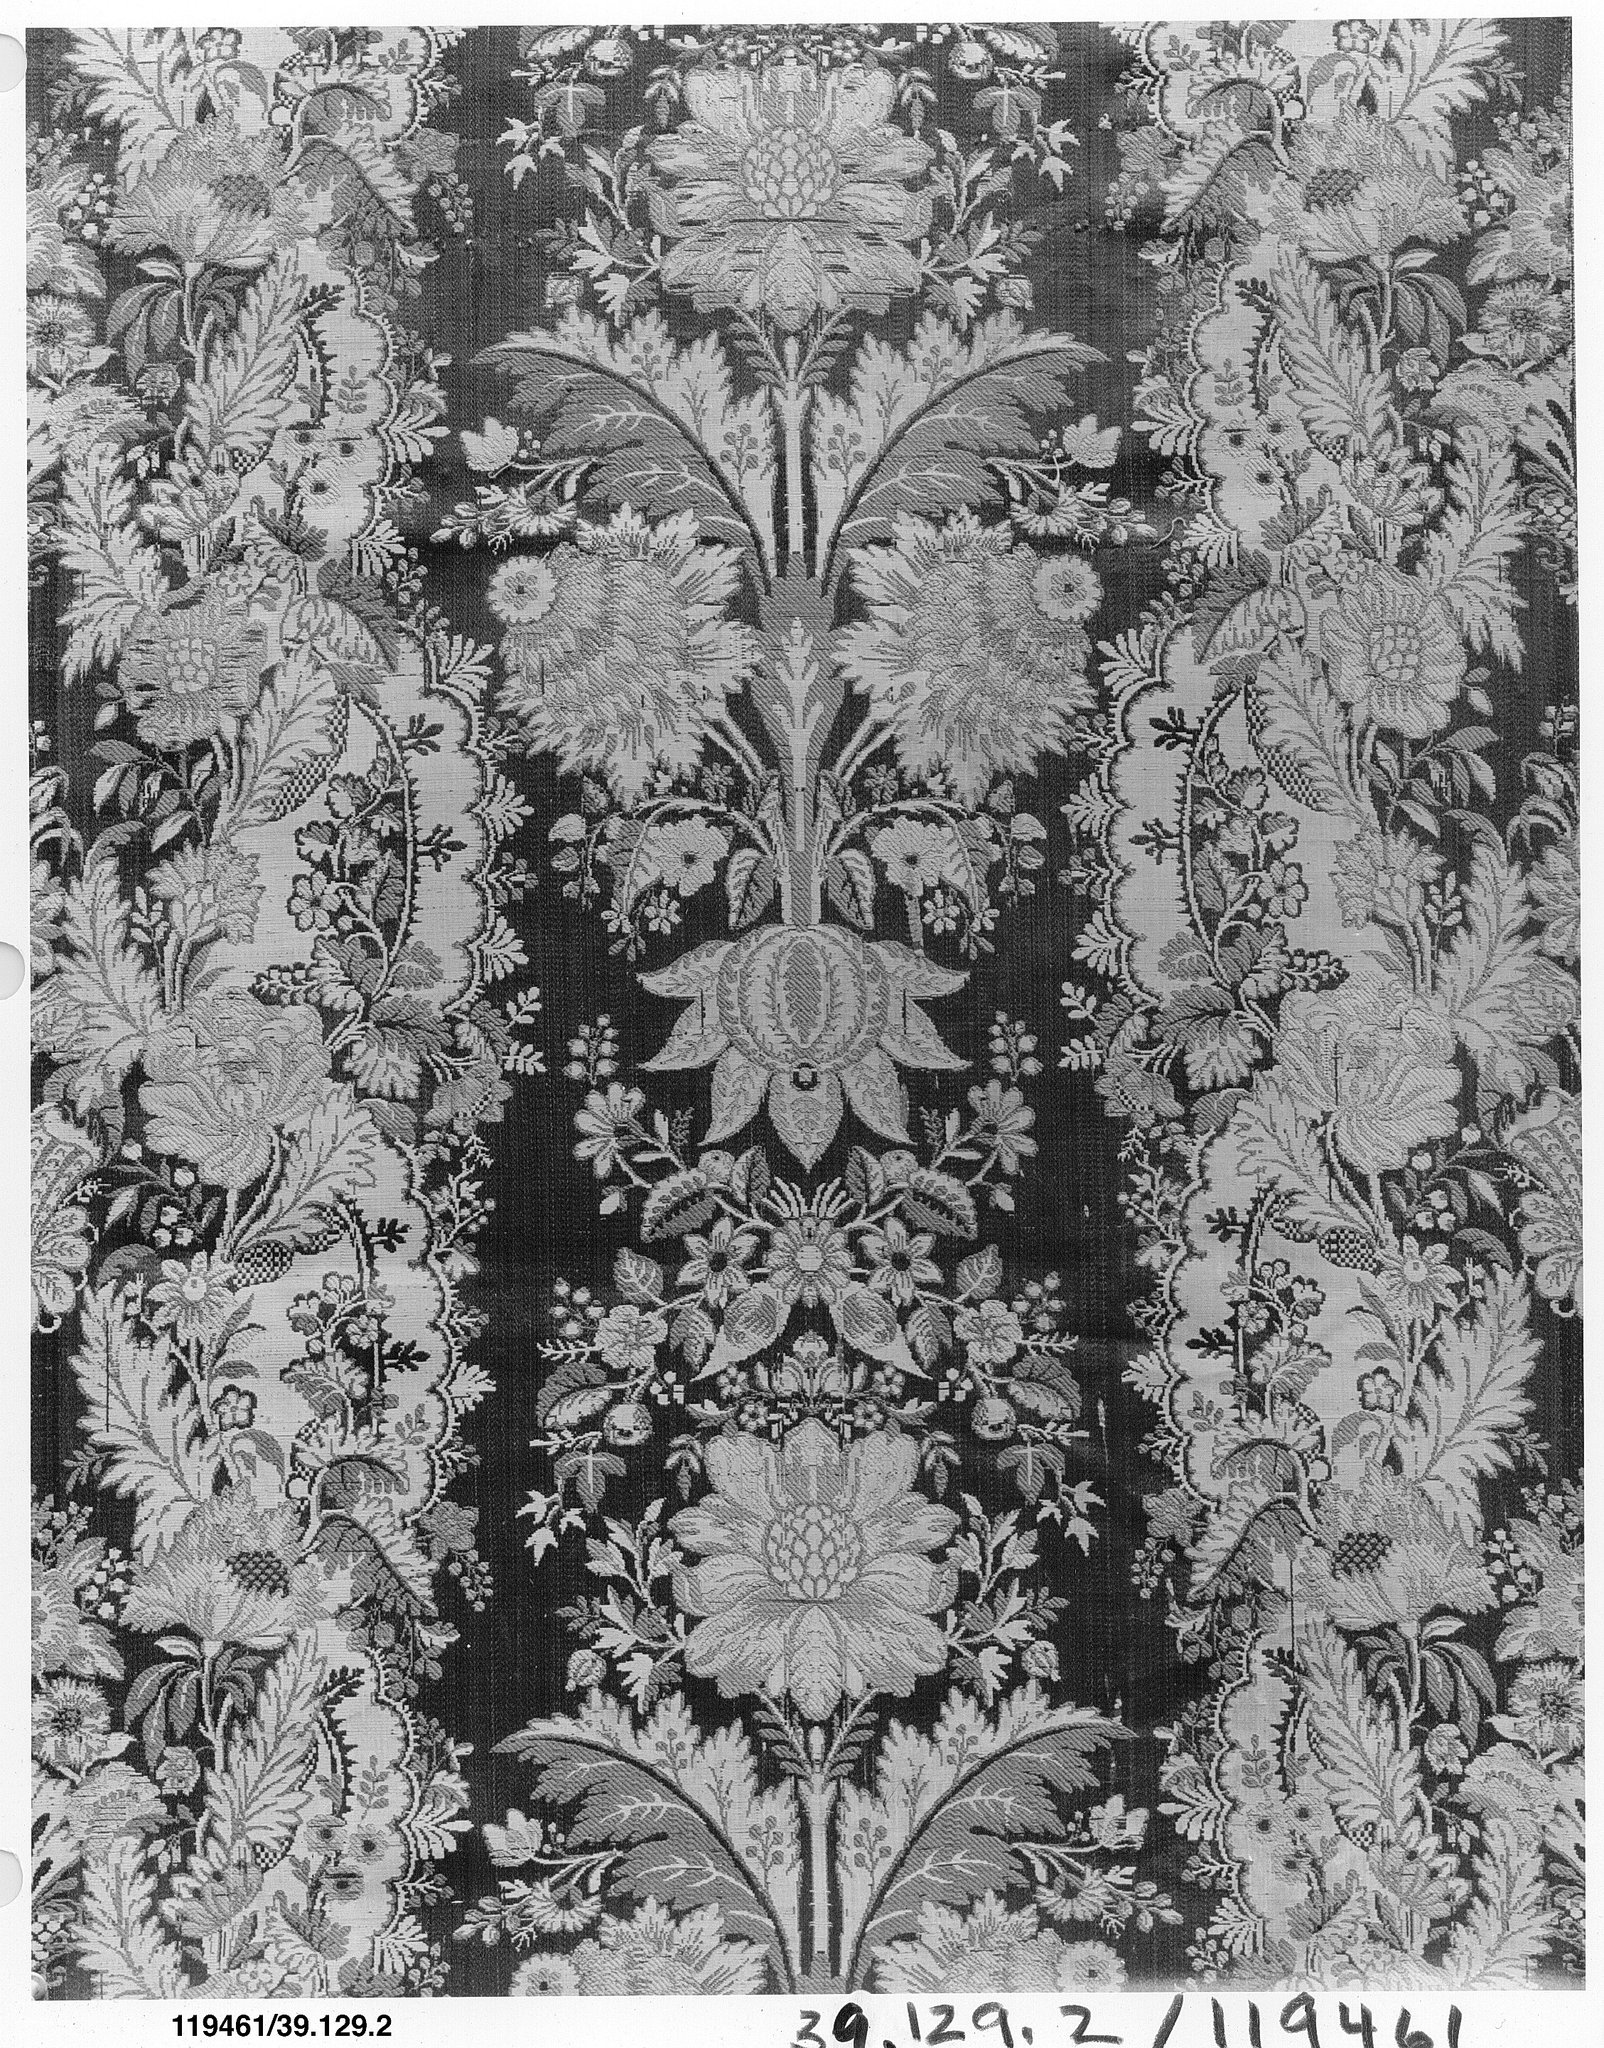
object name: piece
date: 1725-1730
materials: silk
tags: flowers,leaves